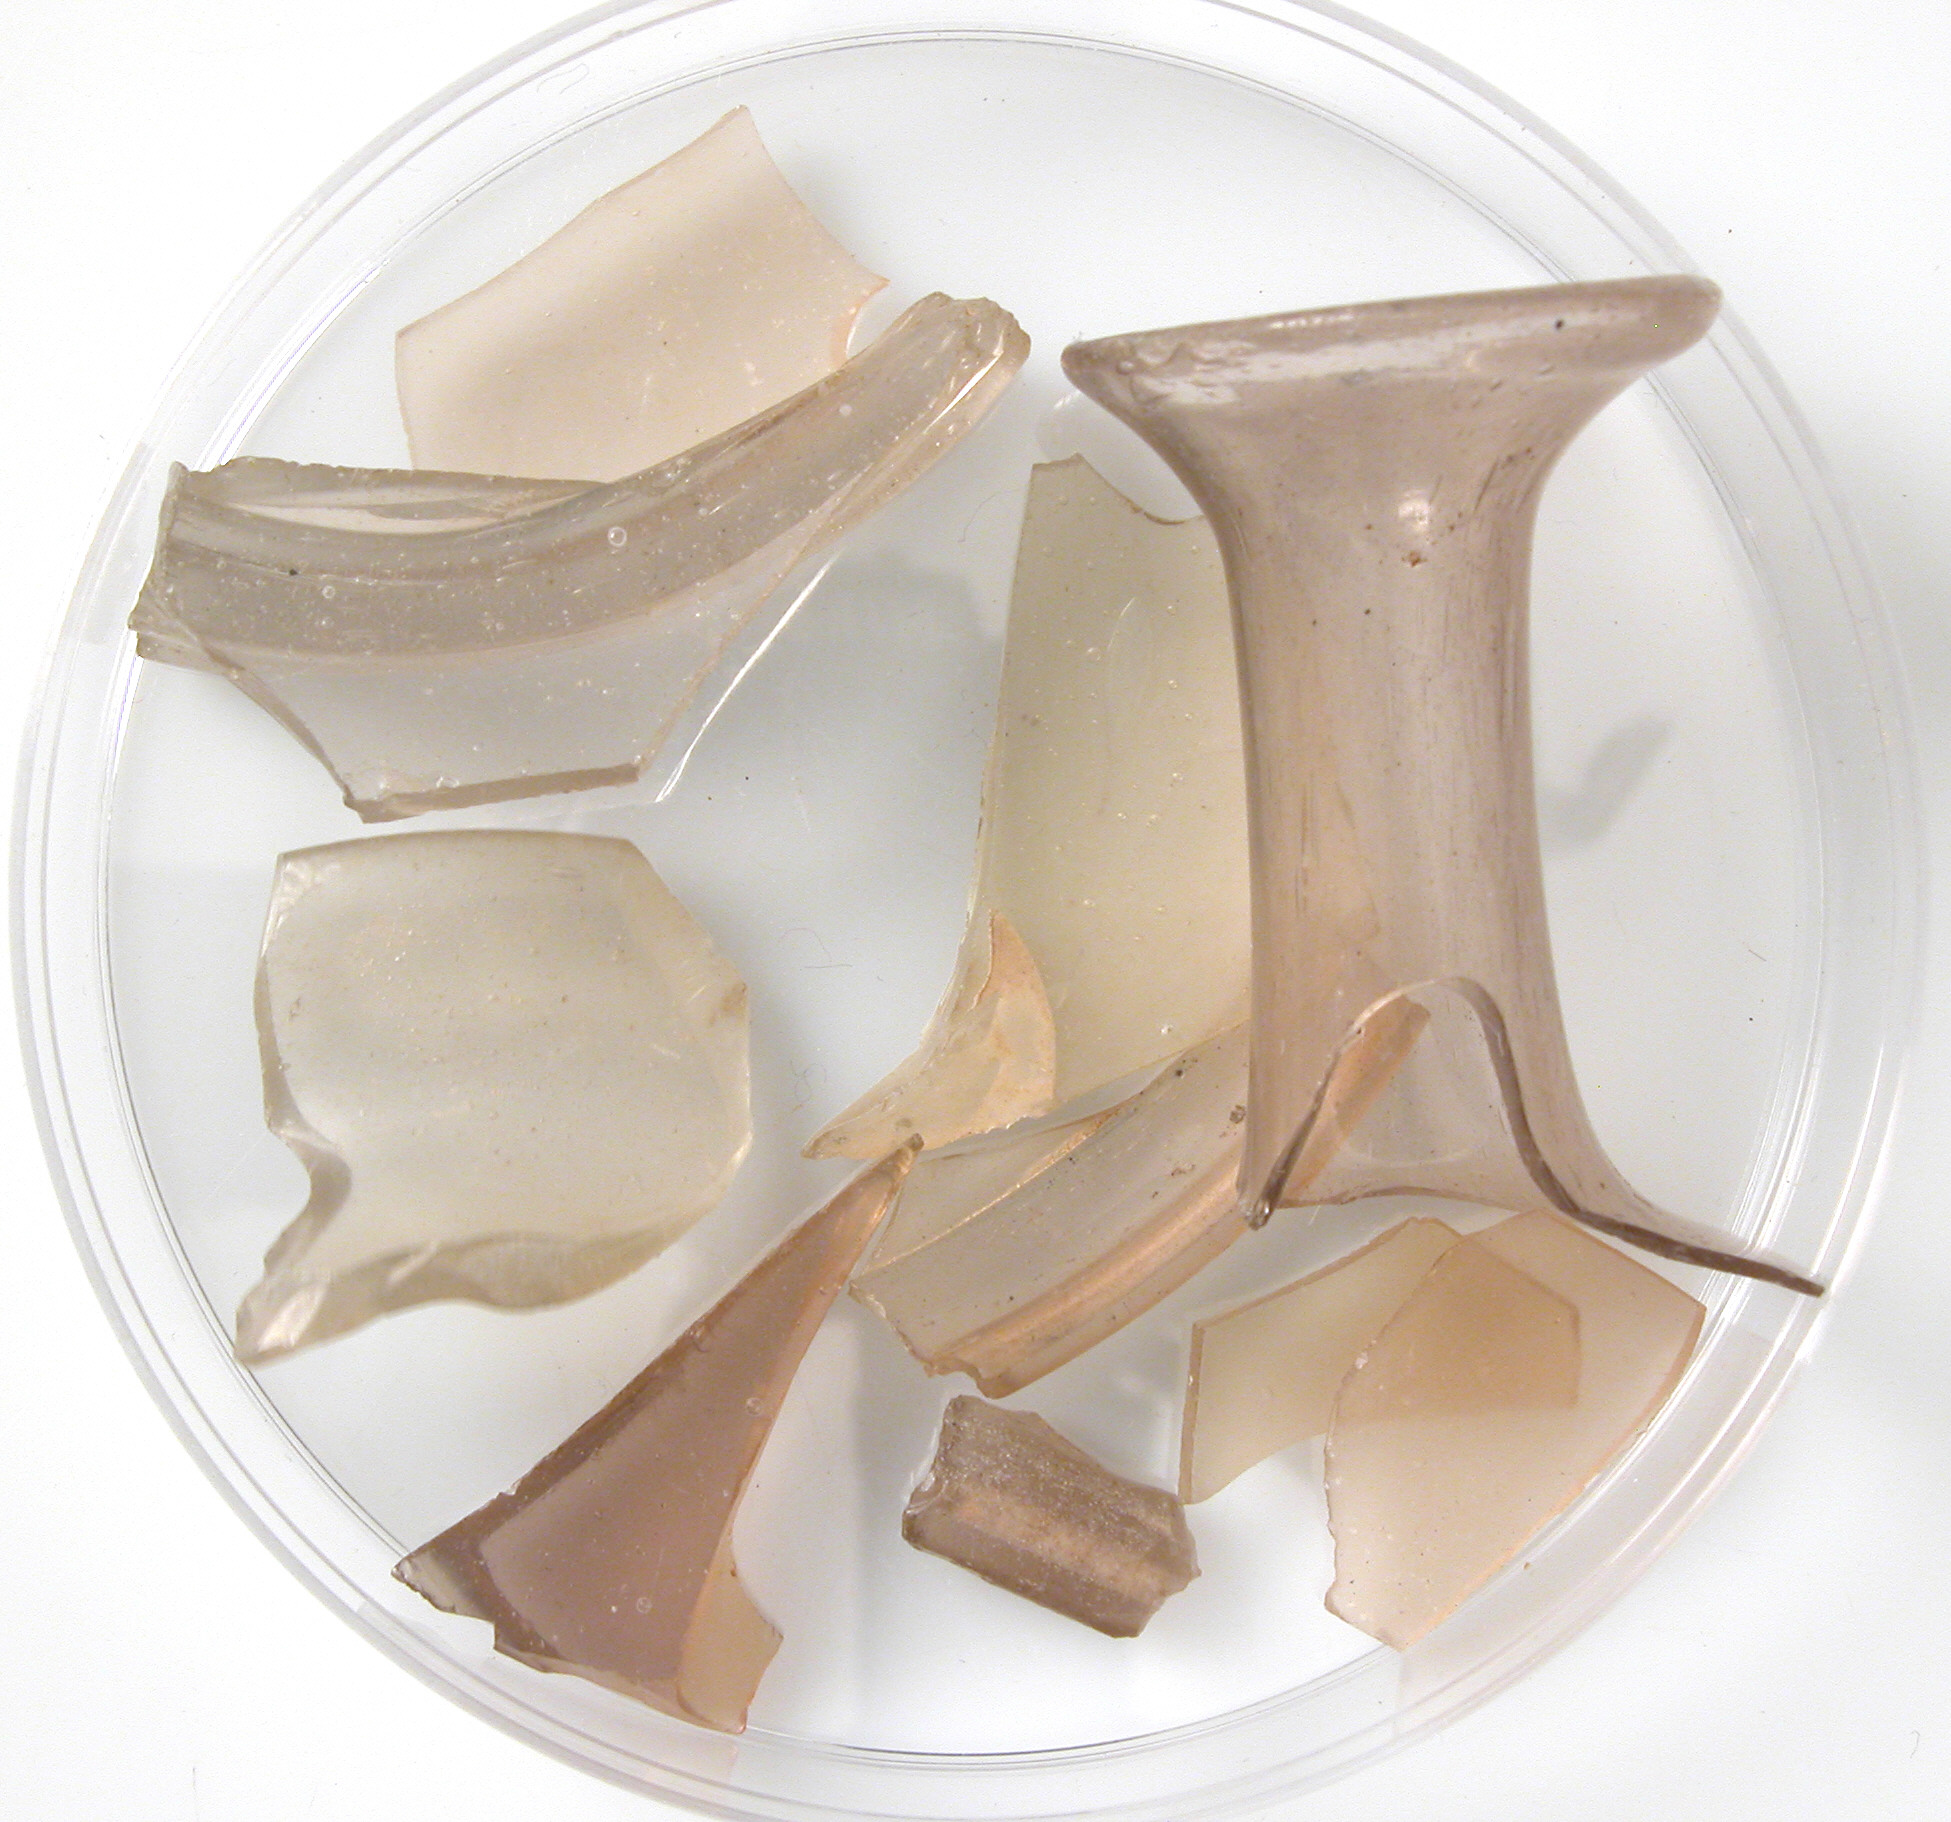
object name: fragment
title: Glass Fragments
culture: coptic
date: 301-700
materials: glass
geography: egypt